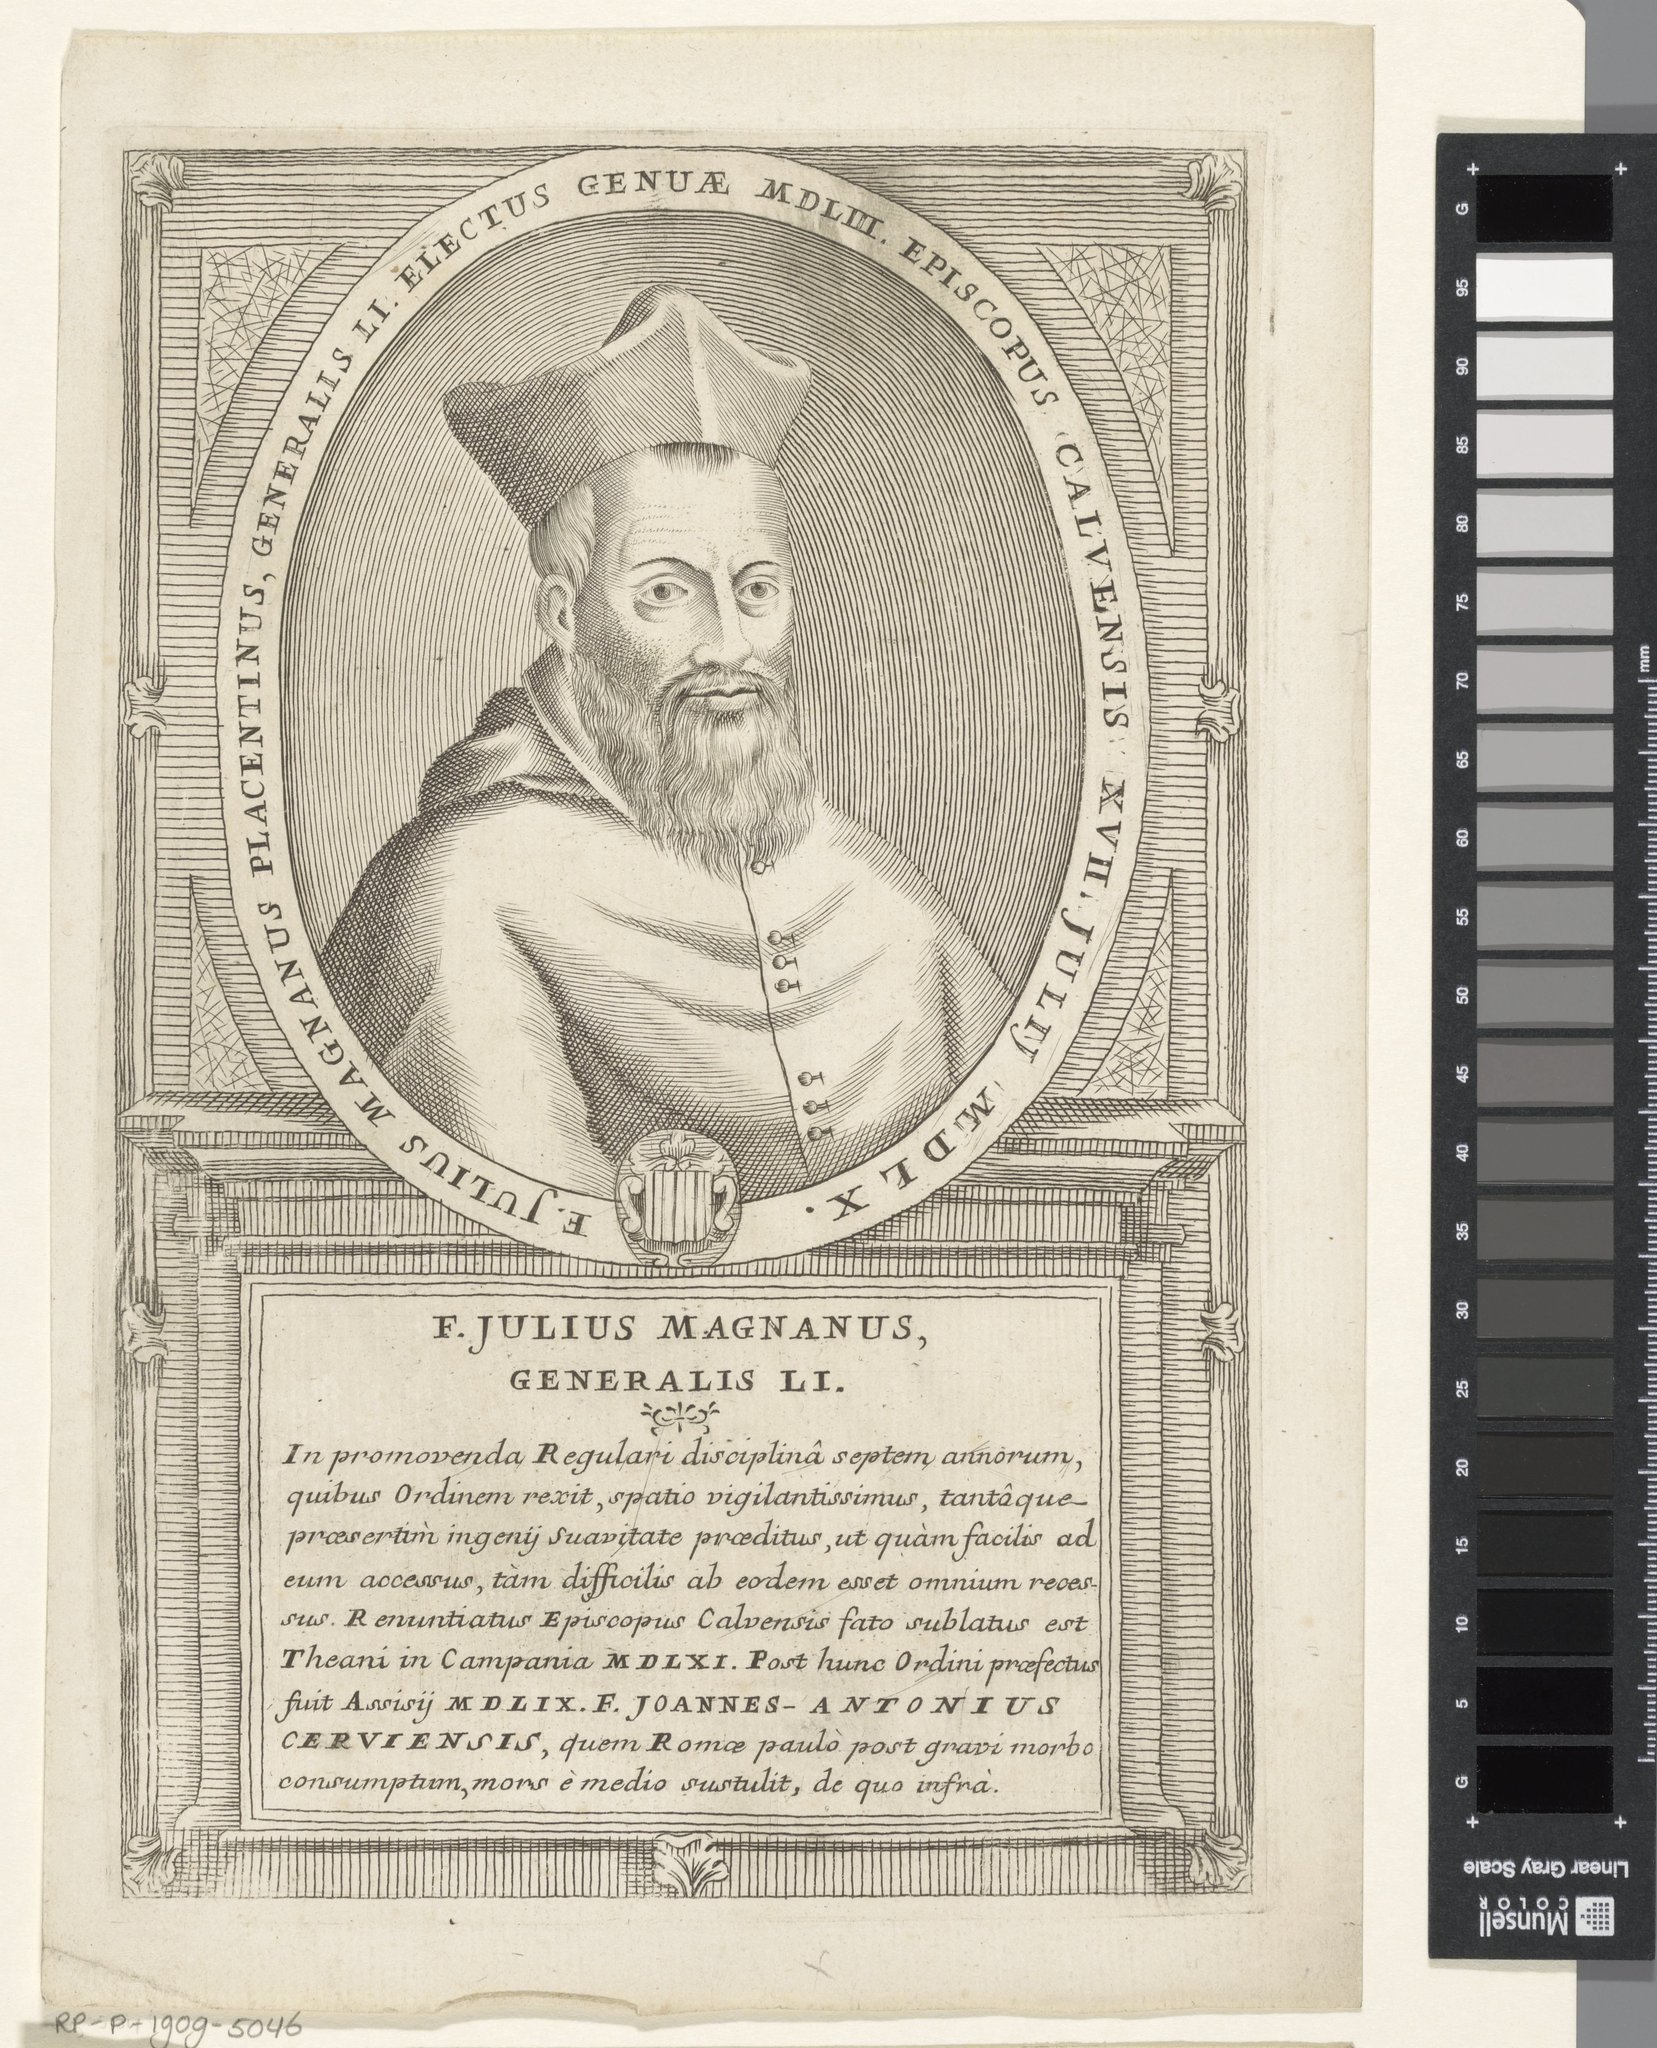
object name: print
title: Portretten van Ministers Generaal van de franciscaner orde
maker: antonio luciani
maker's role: print maker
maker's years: 1700-1738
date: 1710-1738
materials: paper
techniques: engraving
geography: italy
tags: clergyman, historical persons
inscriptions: collector's mark: Lugt 2228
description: Deze prent maakt deel uit van een groep van 60 portretten.